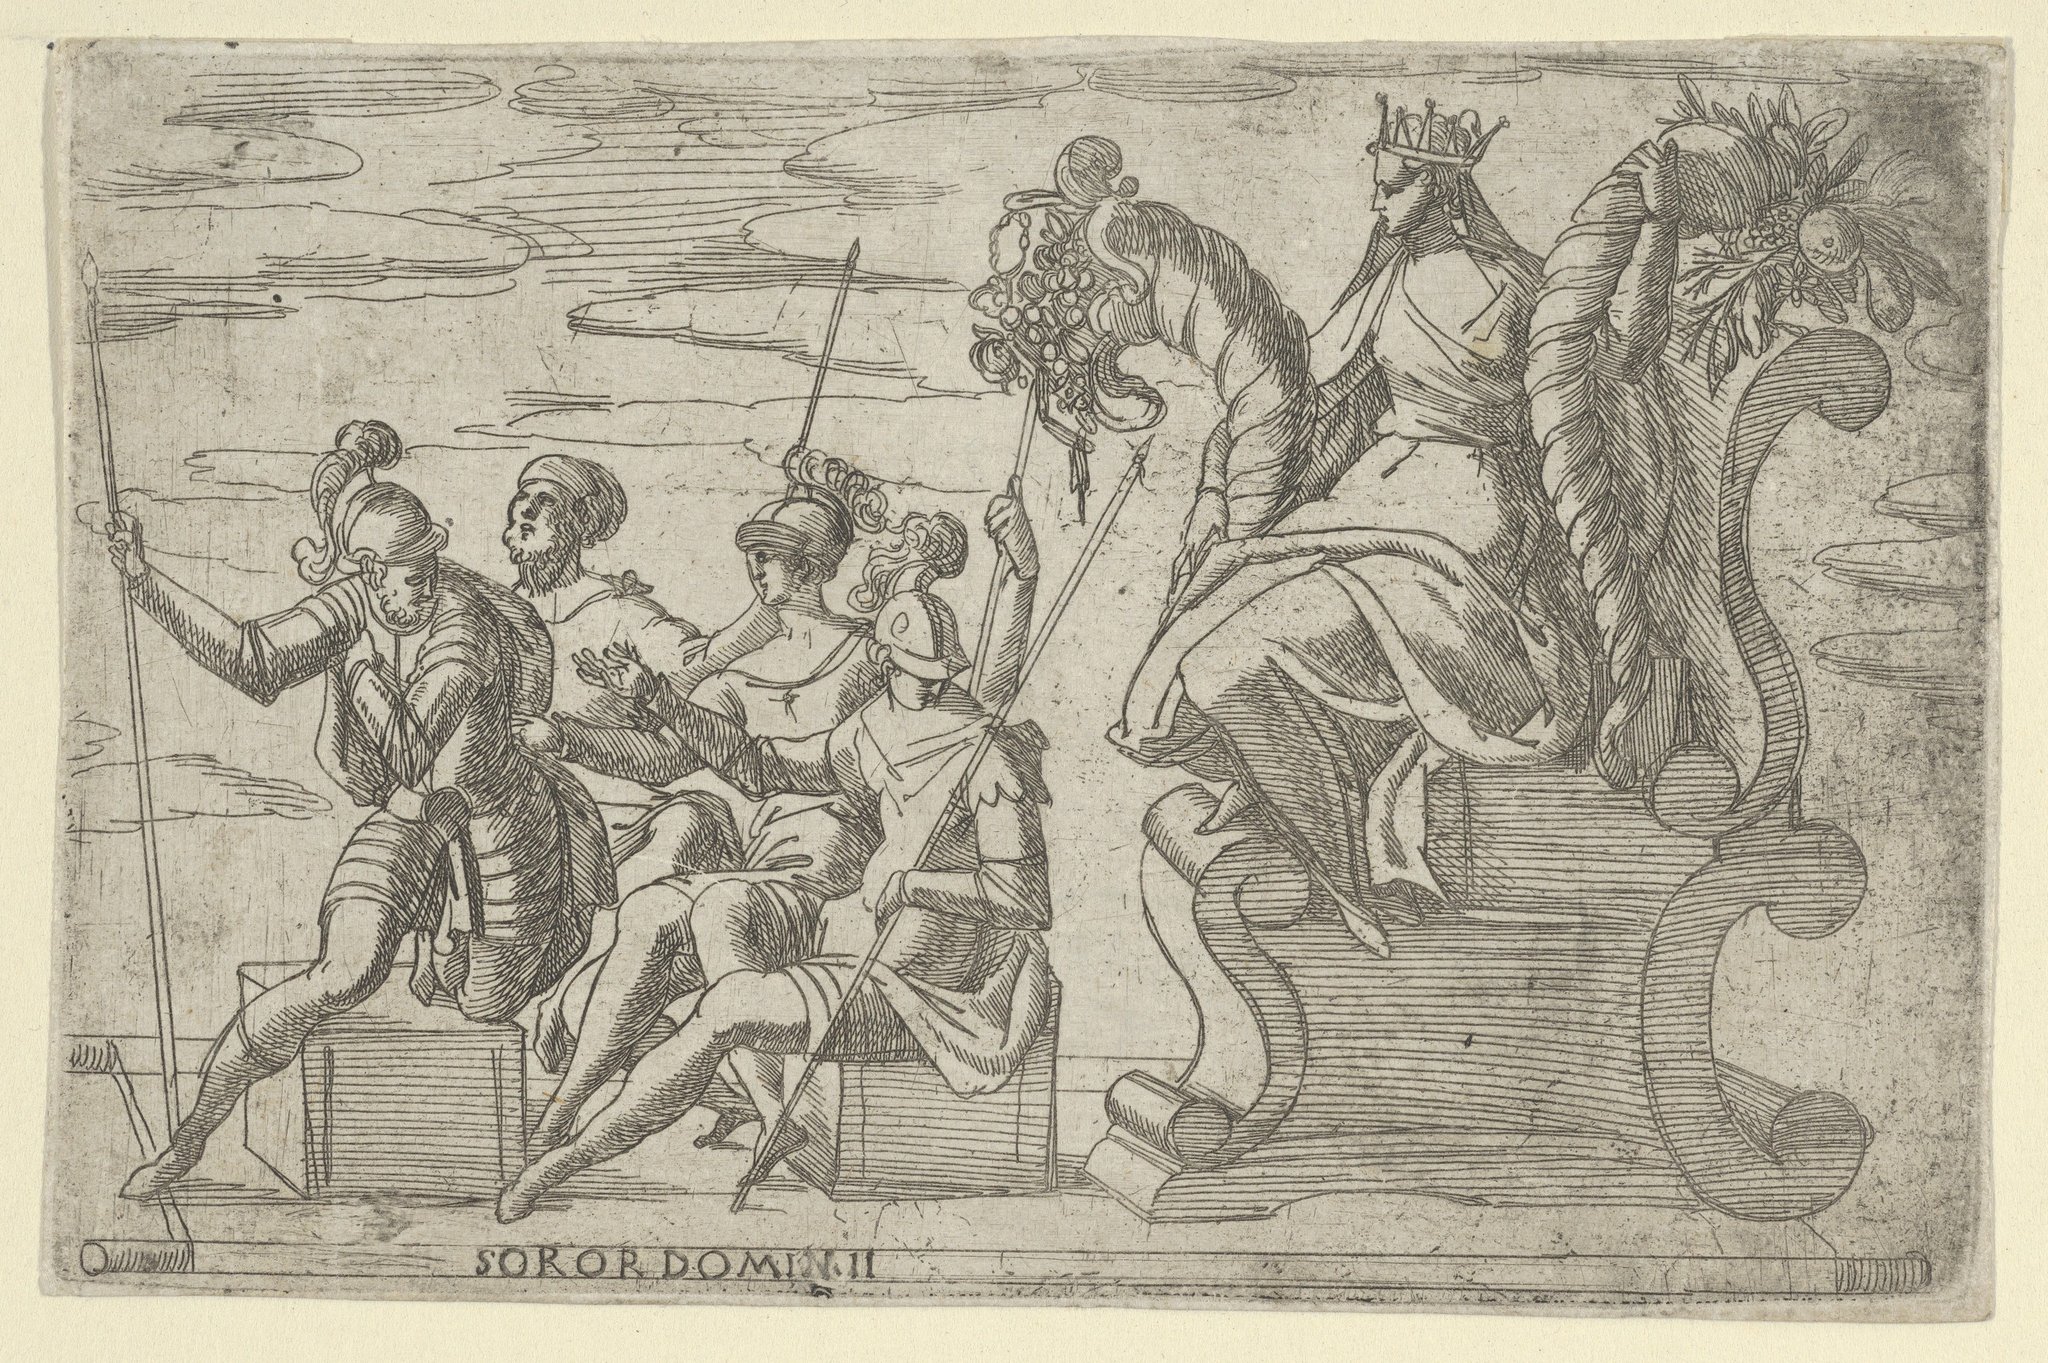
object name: print, fete, ornament architecture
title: Soror Domin Il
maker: anonymous, italian, 16th century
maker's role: artist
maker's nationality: italian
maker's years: 1500-1600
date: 1501-1600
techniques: etching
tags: soldiers,weapons,men